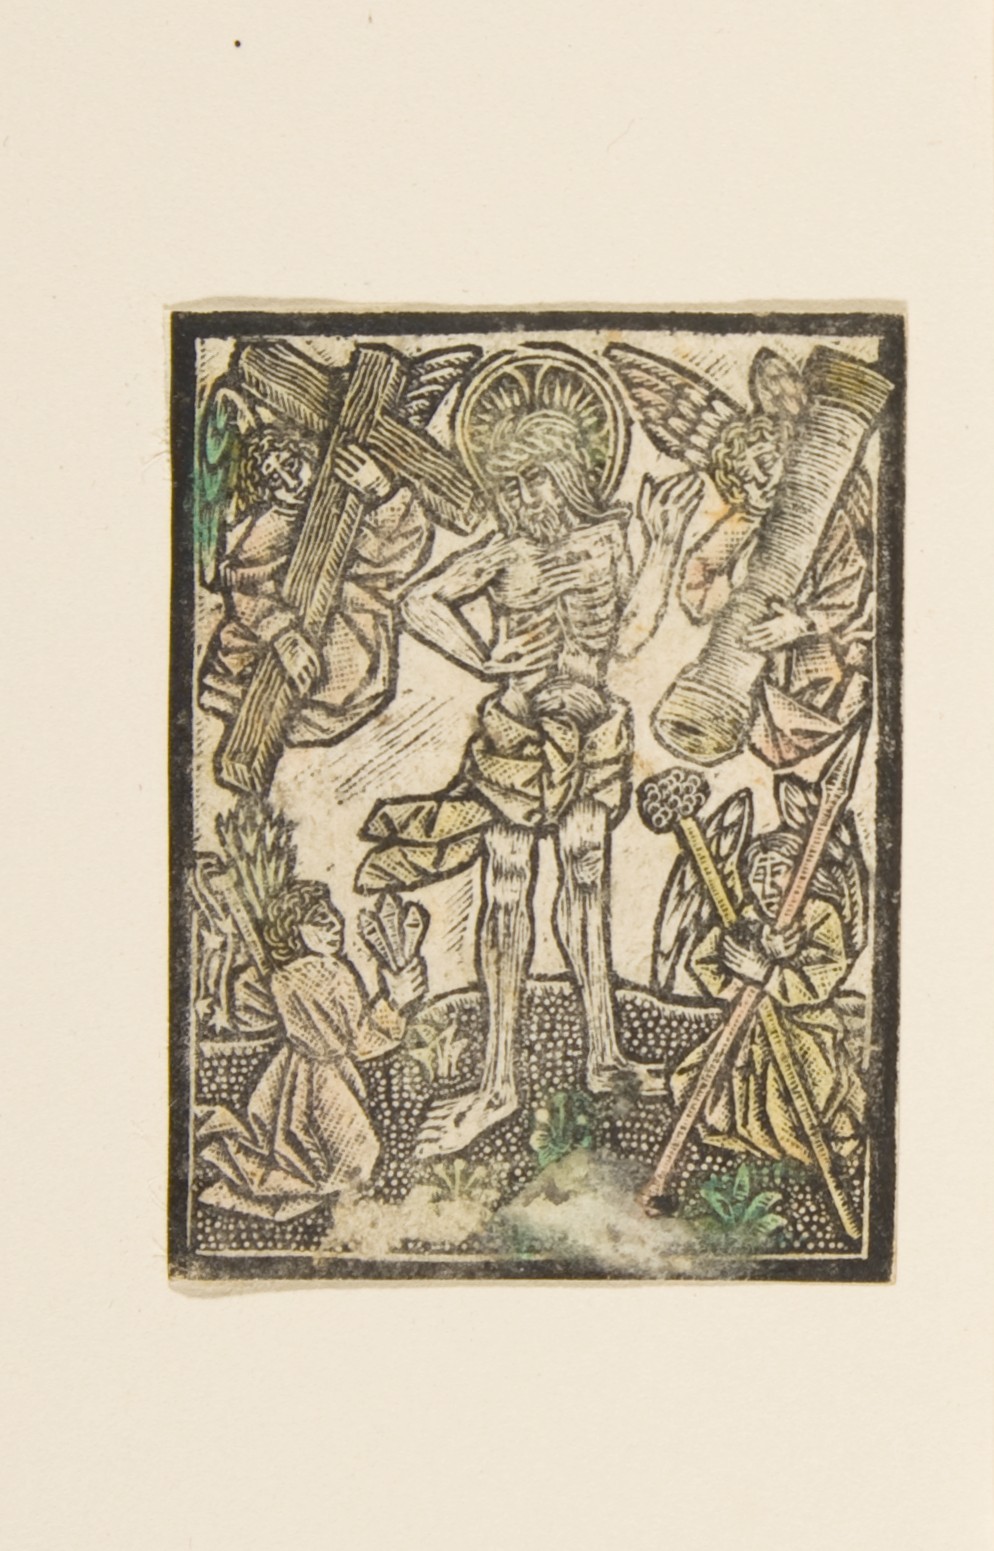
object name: print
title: The Man of Sorrows with Angels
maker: anonymous, german, 15th century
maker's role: artist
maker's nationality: german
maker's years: 1400-1500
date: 1401-1500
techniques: hand coloring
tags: angels,cross,jesus